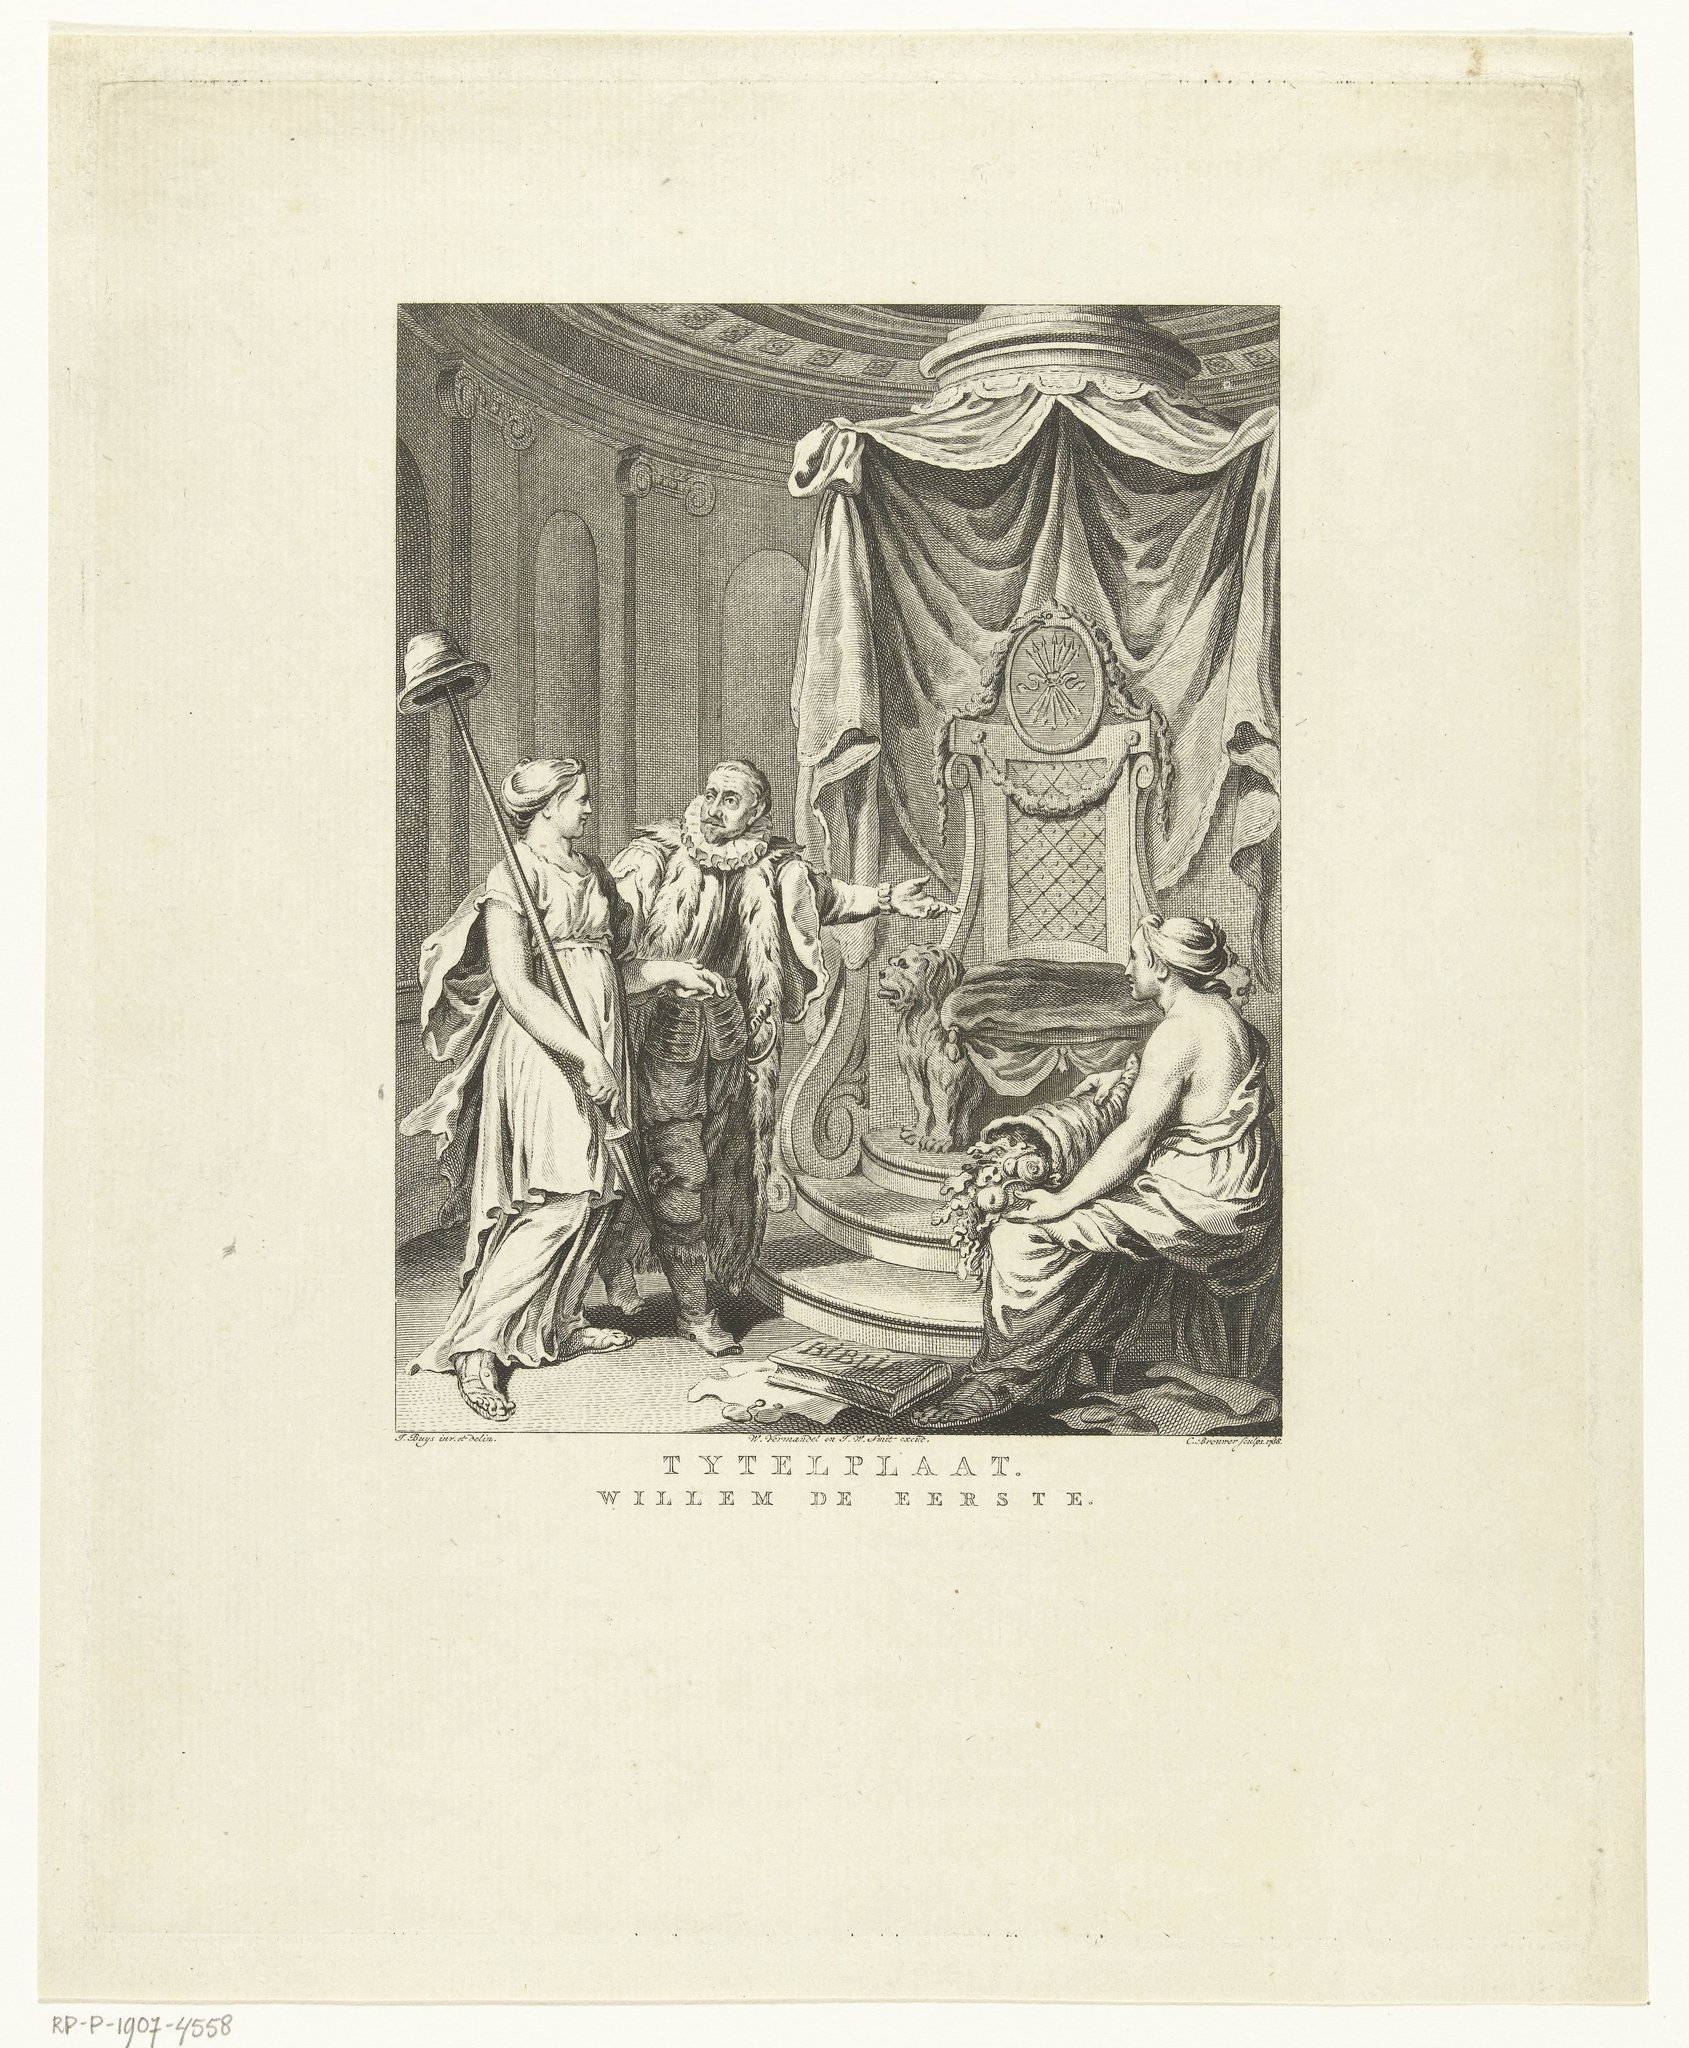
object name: print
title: Titelprent met prins Willem I van Oranje die de Hollandse Maagd naar een troon leidt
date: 1788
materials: paper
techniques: engraving, etching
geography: netherlands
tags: william i (prince of orange), coat of arms (as symbol of the state, etc.), 'cornucopia', horn of plenty, symbols of particular nations, states, districts, etc.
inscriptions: collector's mark: Lugt 2228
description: Titelprent met prins Willem I van Oranje die de Hollandse Maagd aan de hand leidt naar de troon welke wordt bekroond met een wapen van de zeven provinciën. Naast de troon zit de personificatie van Overvloed met een hoorn des overvloeds.